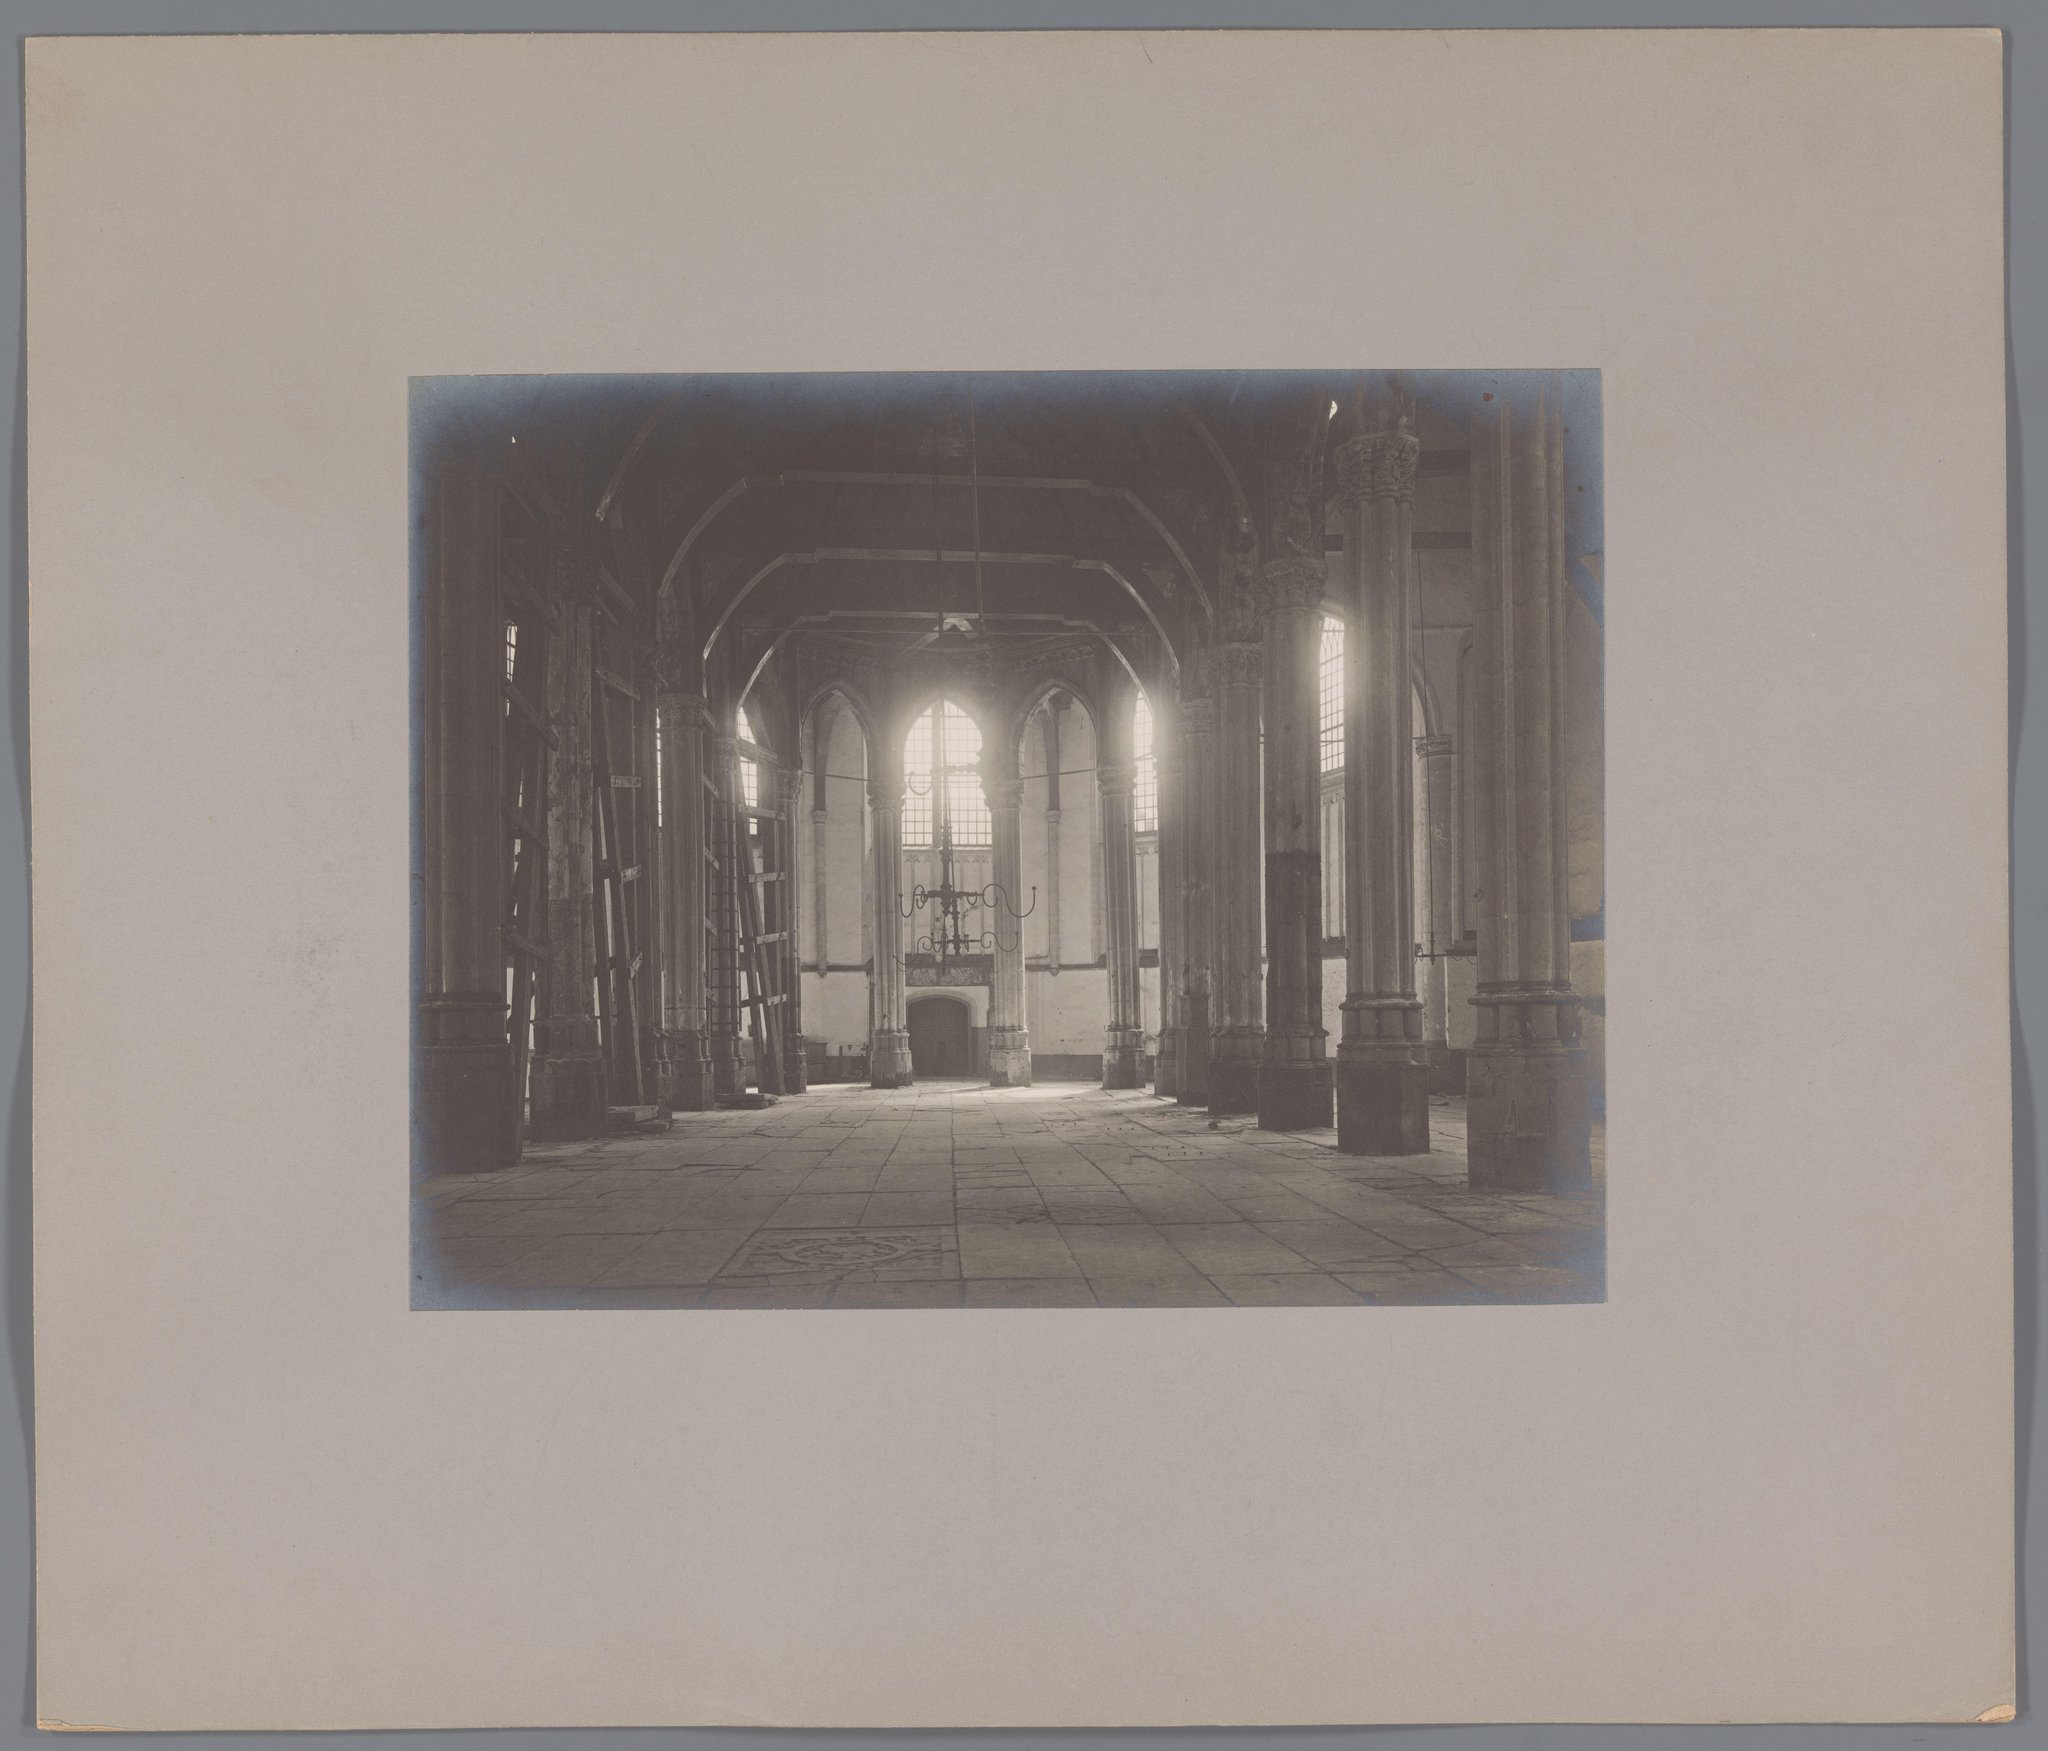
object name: photograph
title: Interieur van de Nieuwezijds Kapel te Amsterdam, tijdens de sloop in 1908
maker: albert adriaansz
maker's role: fotograaf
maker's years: 1877-1941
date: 1908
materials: cardboard, photographic support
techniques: gelatin silver print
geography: amsterdam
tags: interior of church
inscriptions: number: ‘'08.155’, collector's mark: Lugt 2228, inscription: ‘Adriaansz. Photographie/ Planciusstr: No.63/ Amsterdam’